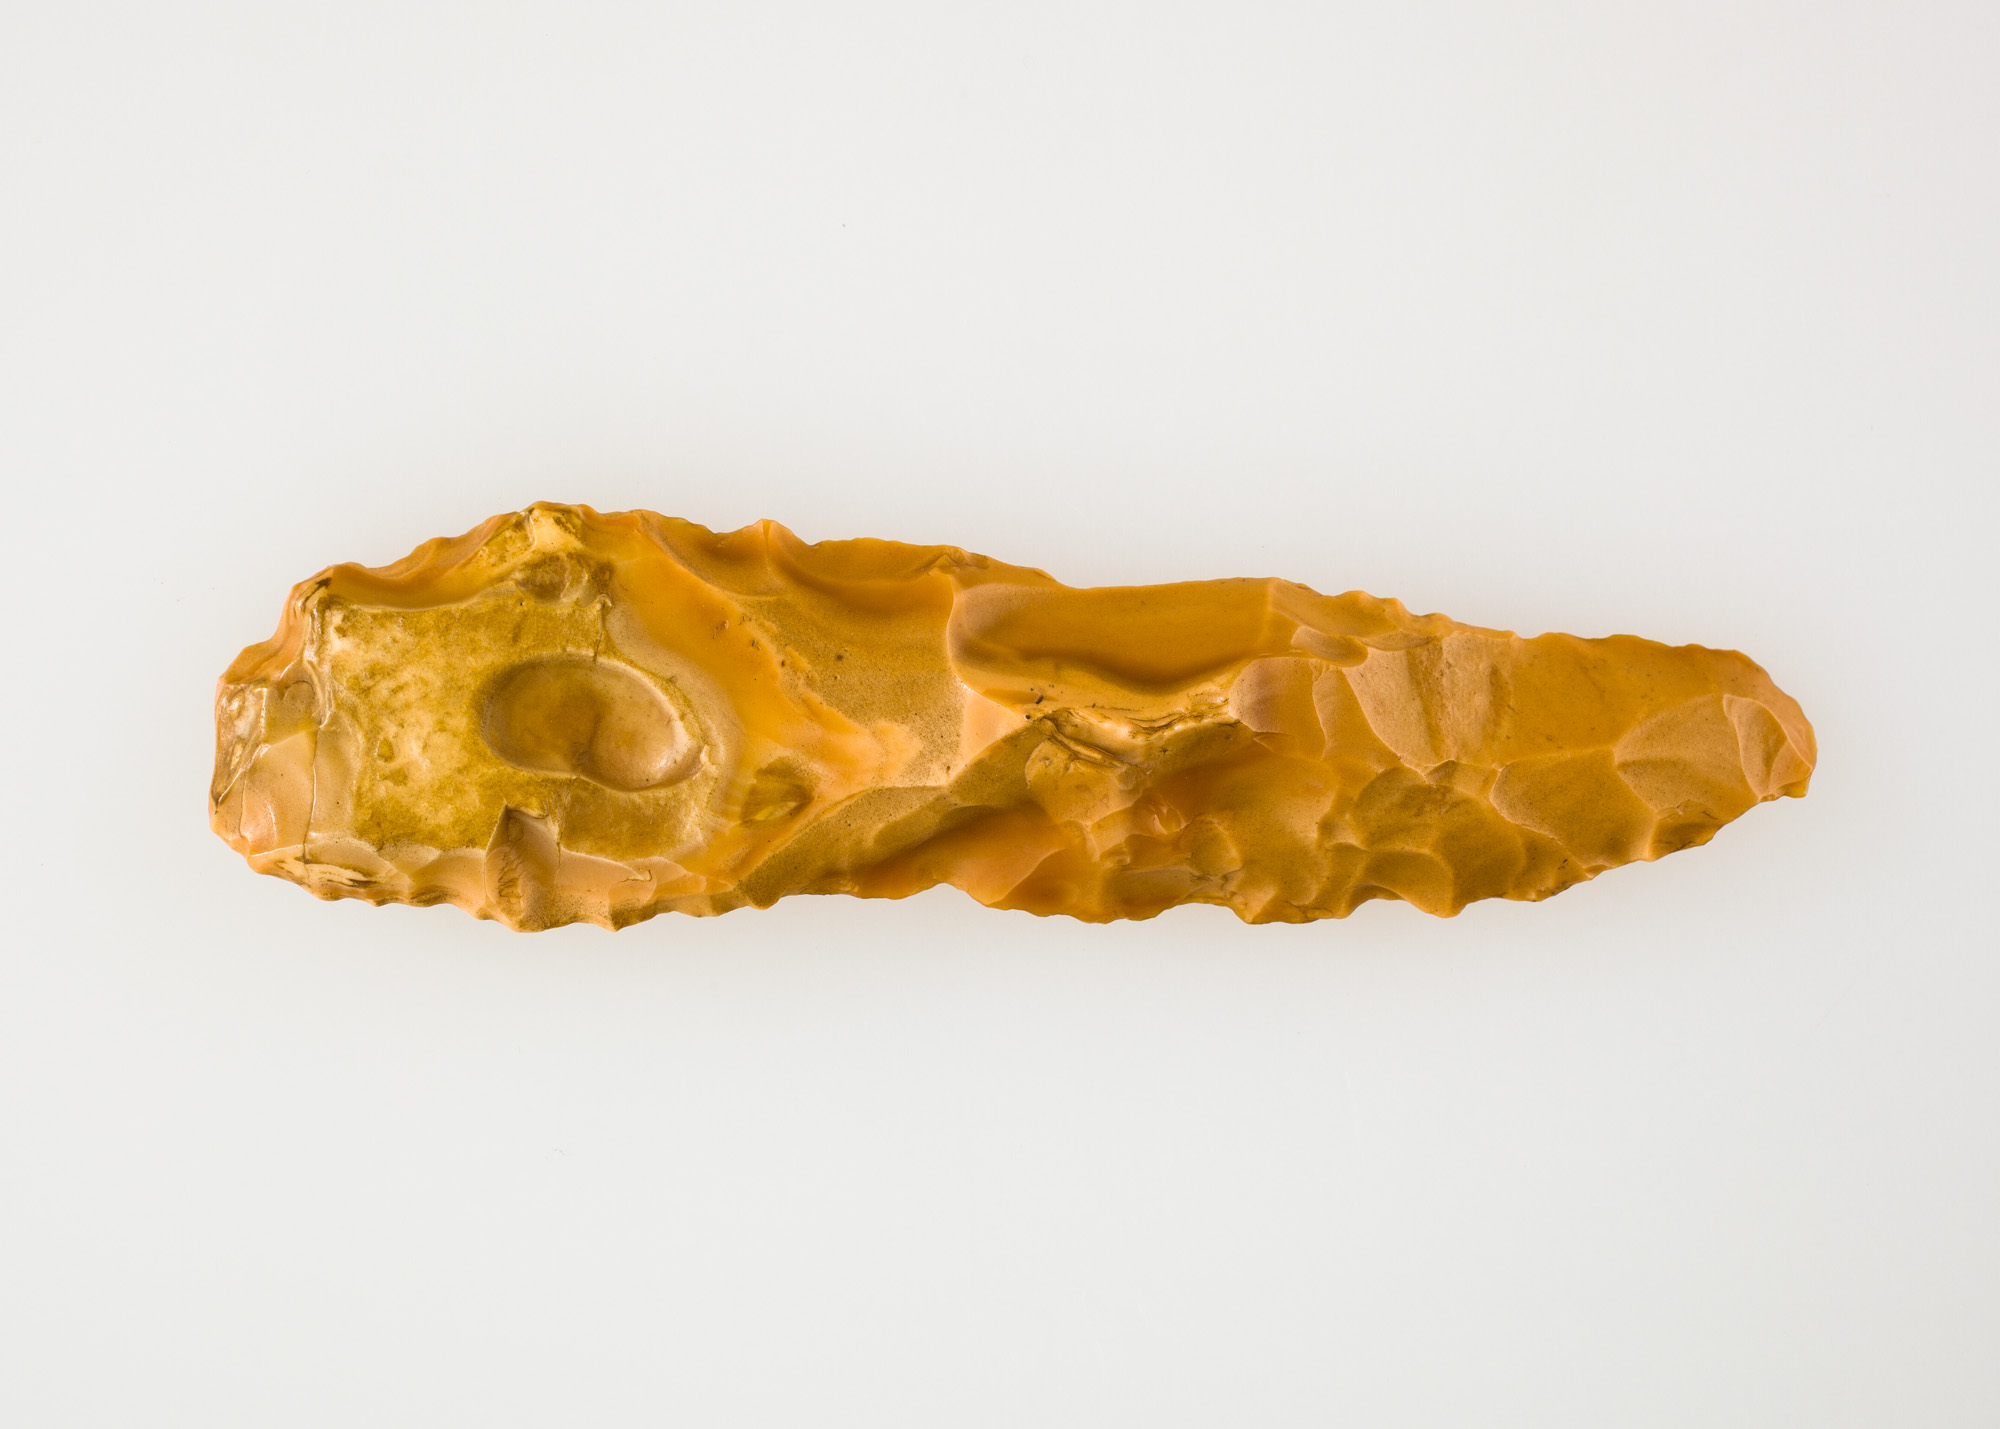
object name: tool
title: Bifacial Tool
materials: stone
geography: egypt